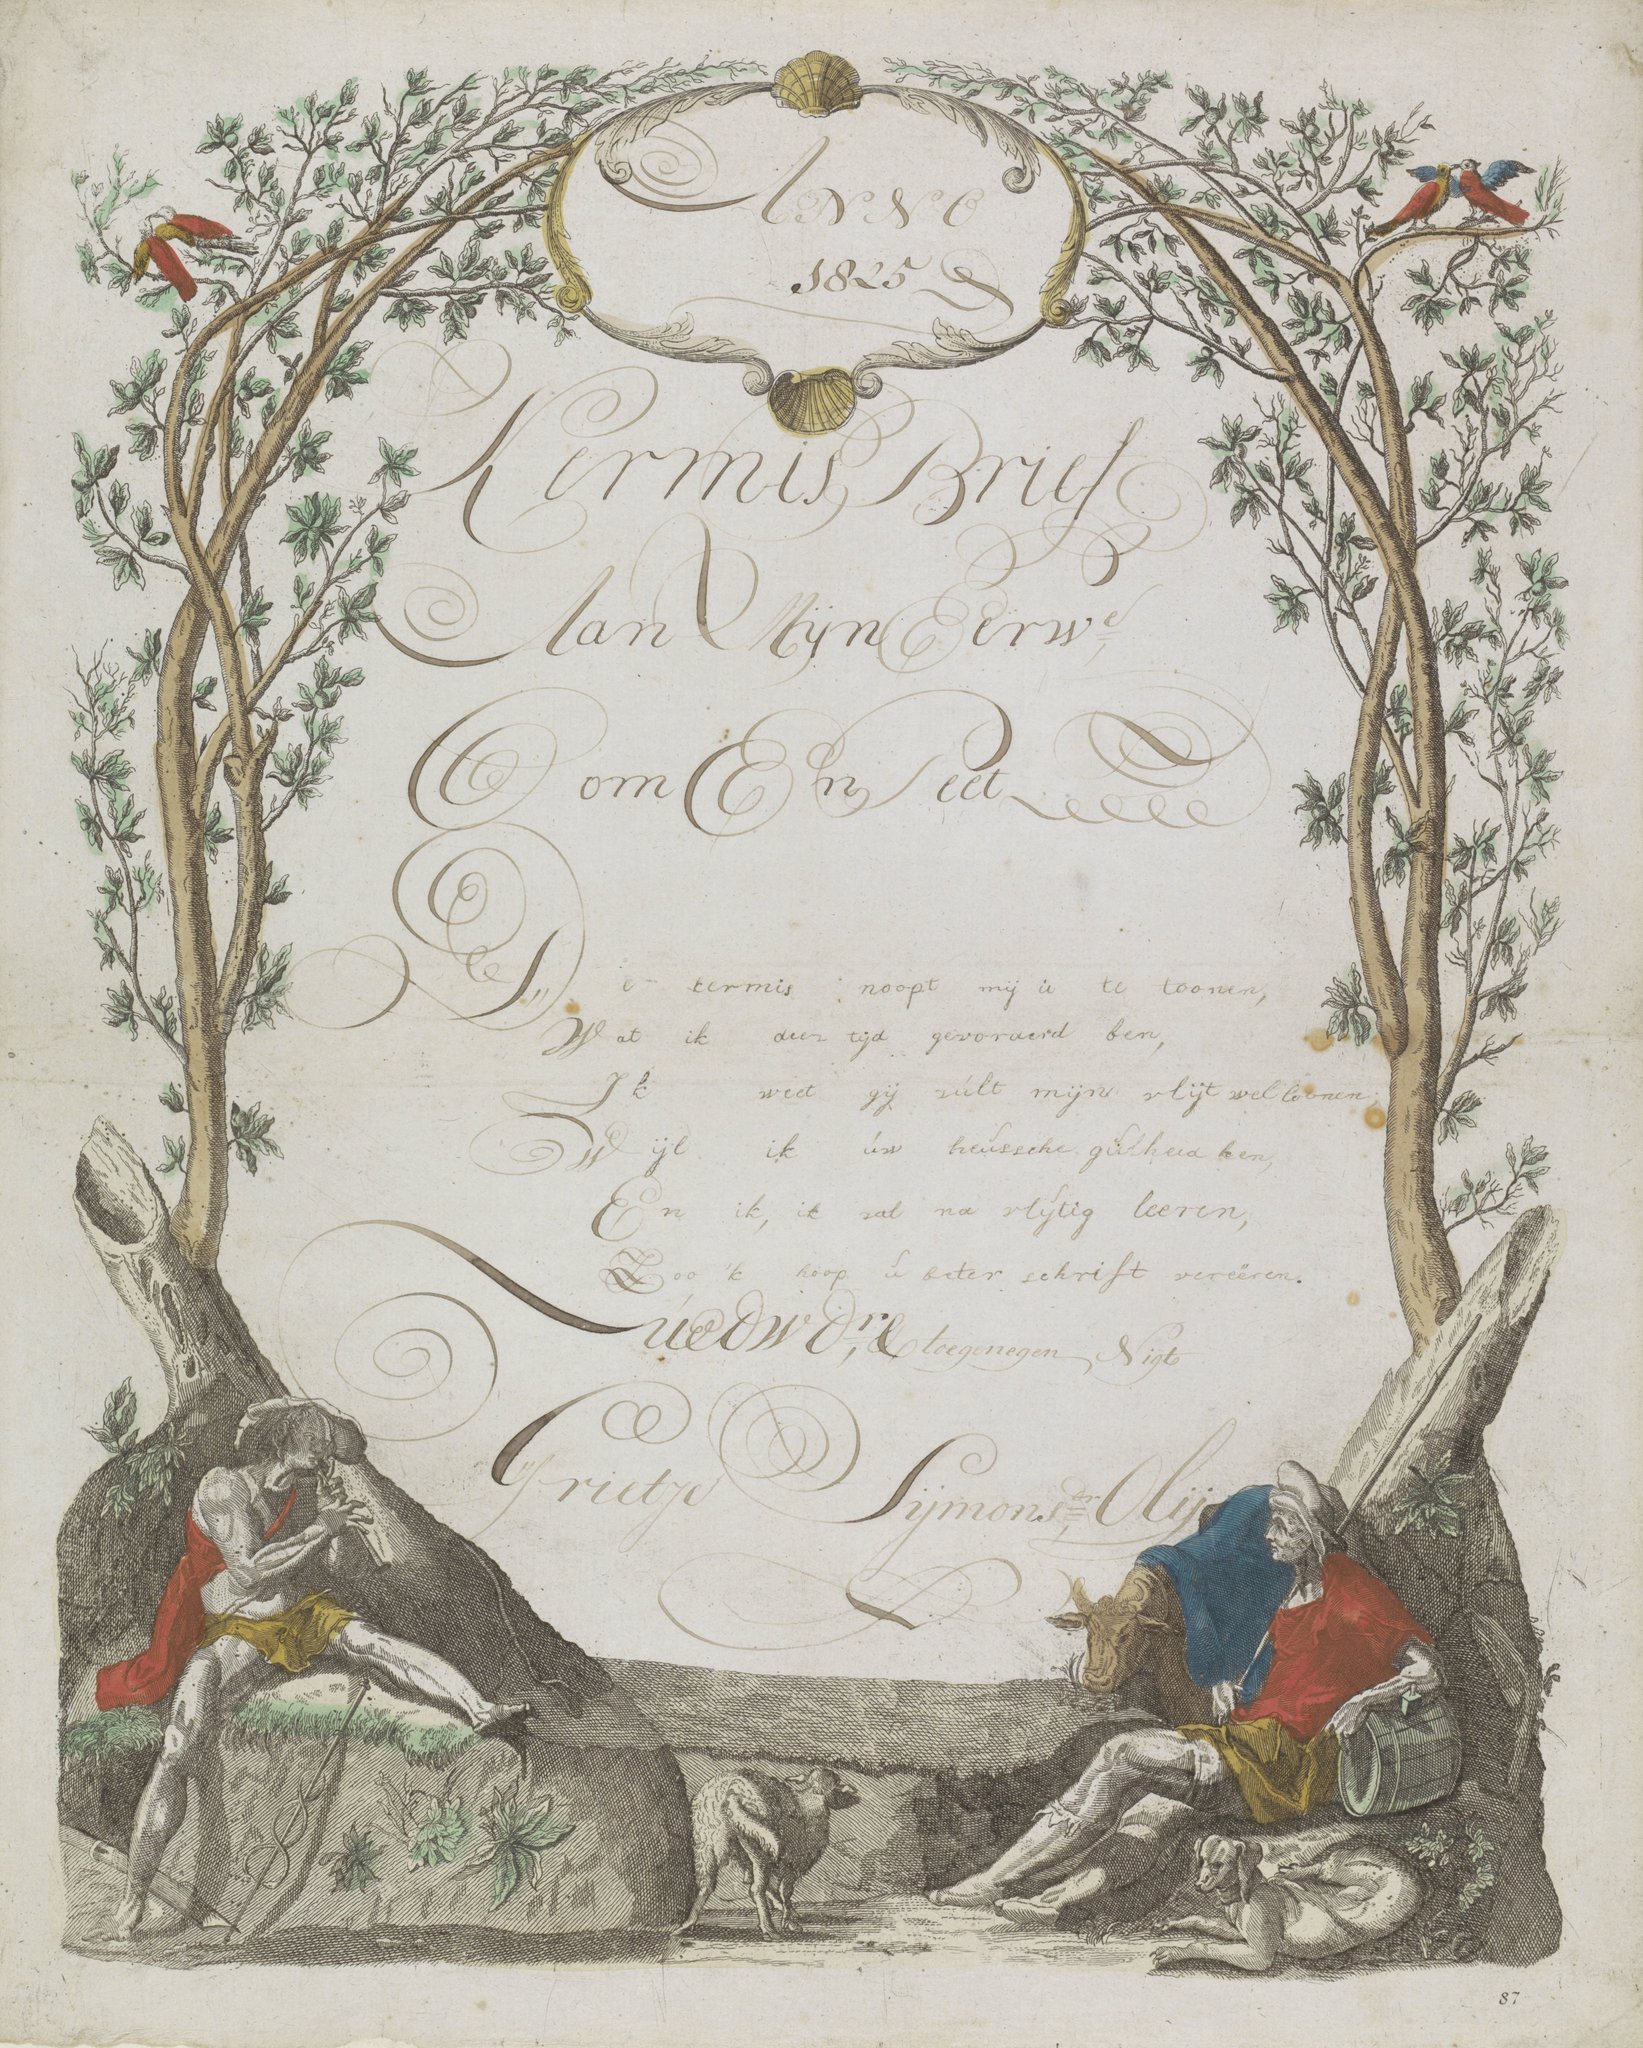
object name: print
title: Wensbrief met Mercurius en Argus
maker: Anonymous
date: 1825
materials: ink, paper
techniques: calligraphy, colour, etching, pen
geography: netherlands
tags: mercury lulls argus into sleep by making music, io as a cow watched by argus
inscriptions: collector's mark: Lugt 2760, inscription: ‘Kermis brief / Aan mijn eerw. / Ook en peet / De kermis noopt mij is te toonen ...’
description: Wensbrief met beschreven cartouche binnen een decoratief kader met een voorstelling van Mercurius en Argus. Handgeschreven bericht in kalligrafie (kermisbrief) door Grietje Sijmons. Olij aan haar oom en peet. Genummerd rechtsonder: 87.